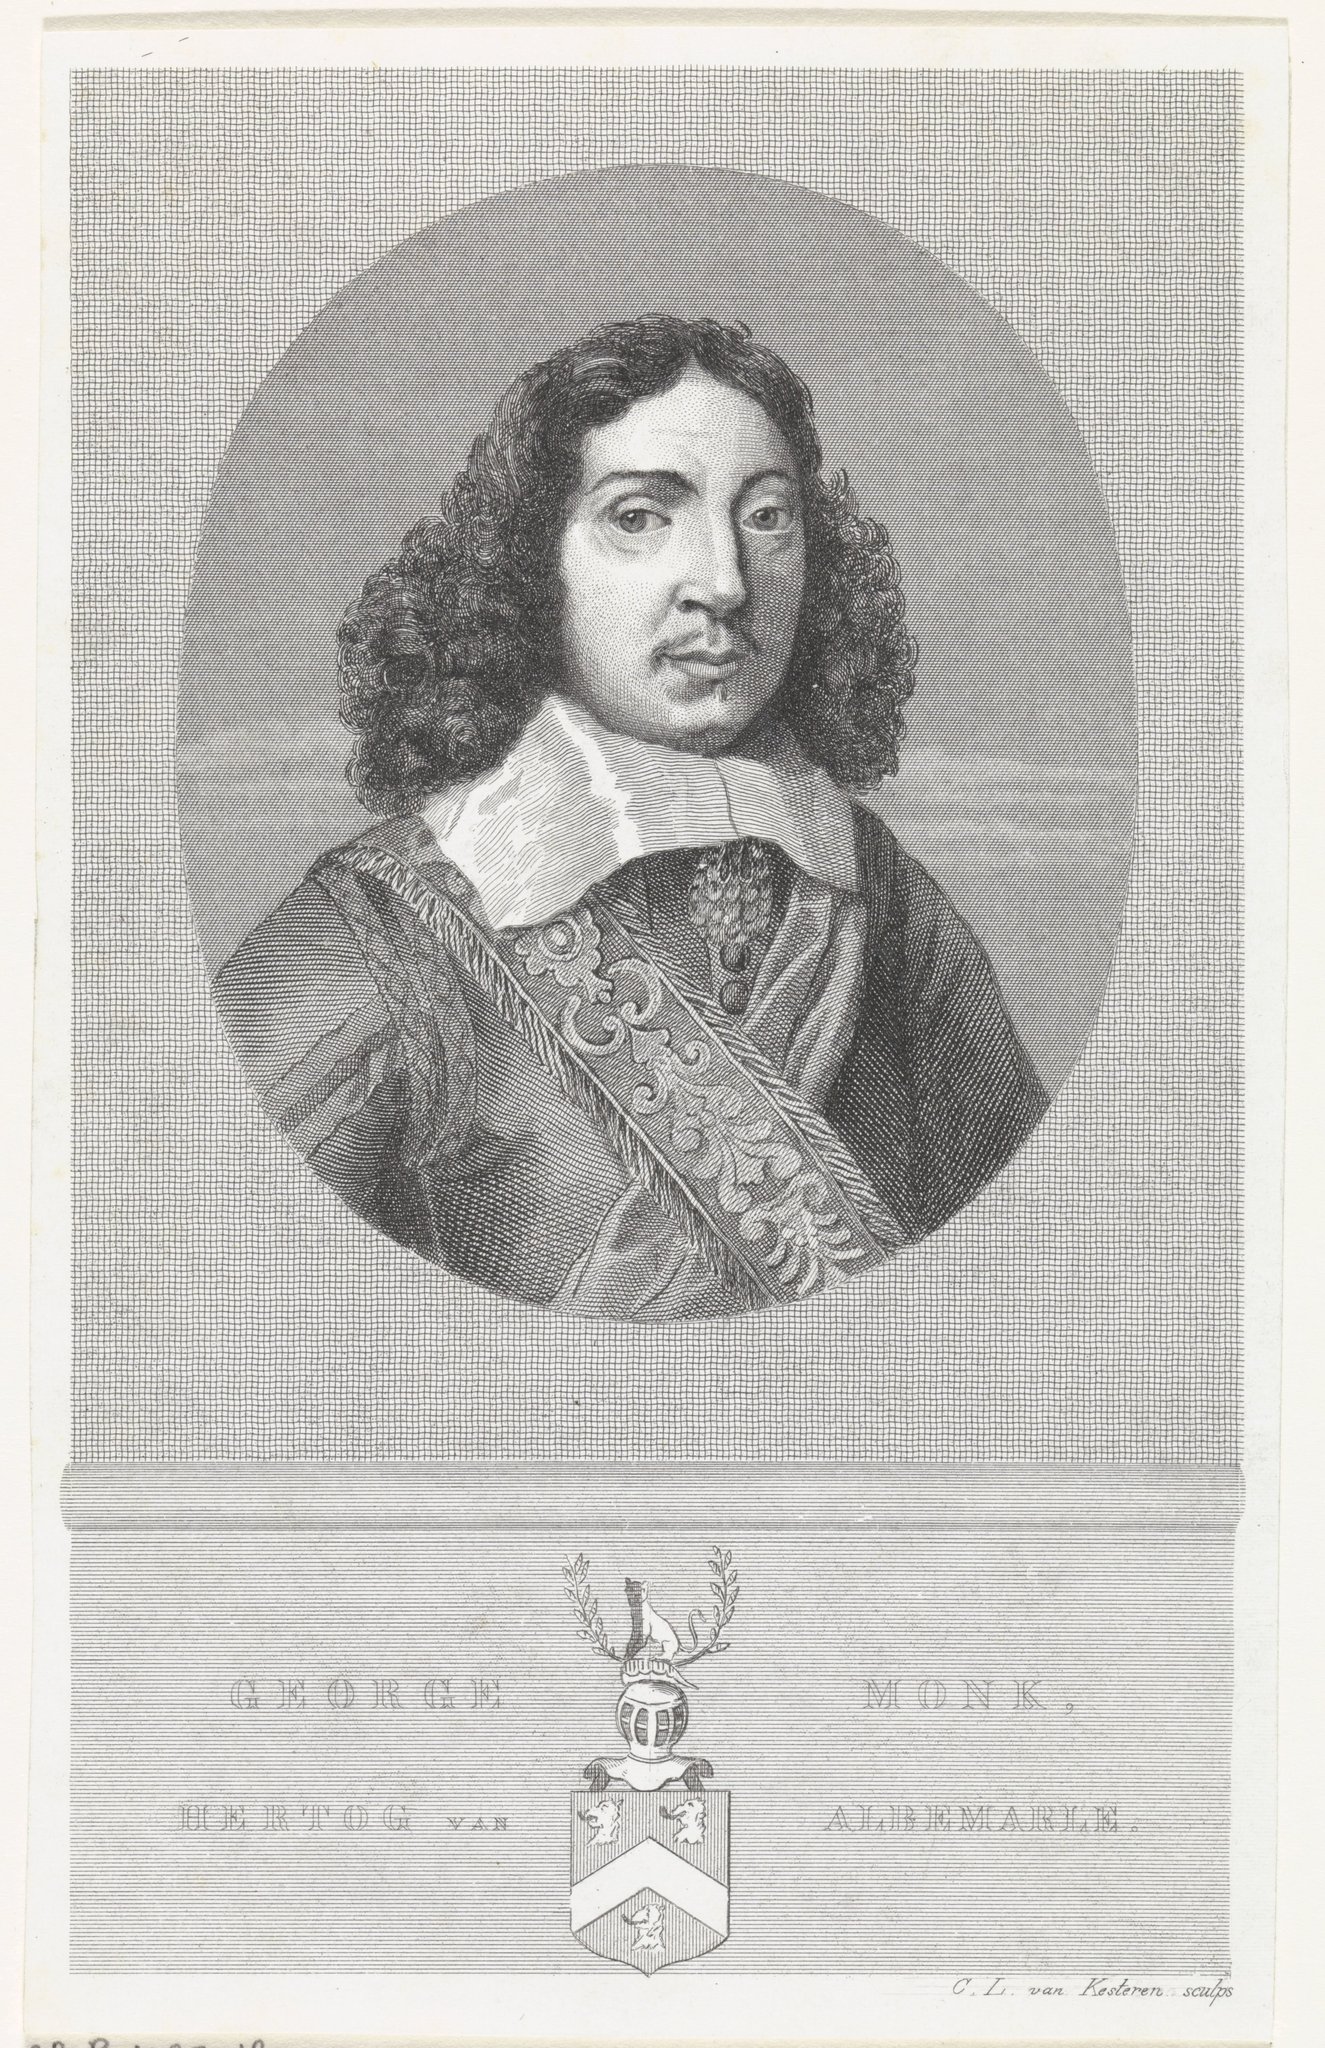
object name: print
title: Portret van George Monk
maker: christiaan lodewijk van kesteren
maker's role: print maker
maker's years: 1832-1897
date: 1842-1897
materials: paper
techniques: engraving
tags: admiraal, staatsman, george monck (hertog van albemarle)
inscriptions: collector's mark: Lugt 2228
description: Portret ten halven lijve in ovaal van George Monk, eerste hertog van Albemarle, Engels admiraal en staatsman. In de marge staat zijn familiewapen.